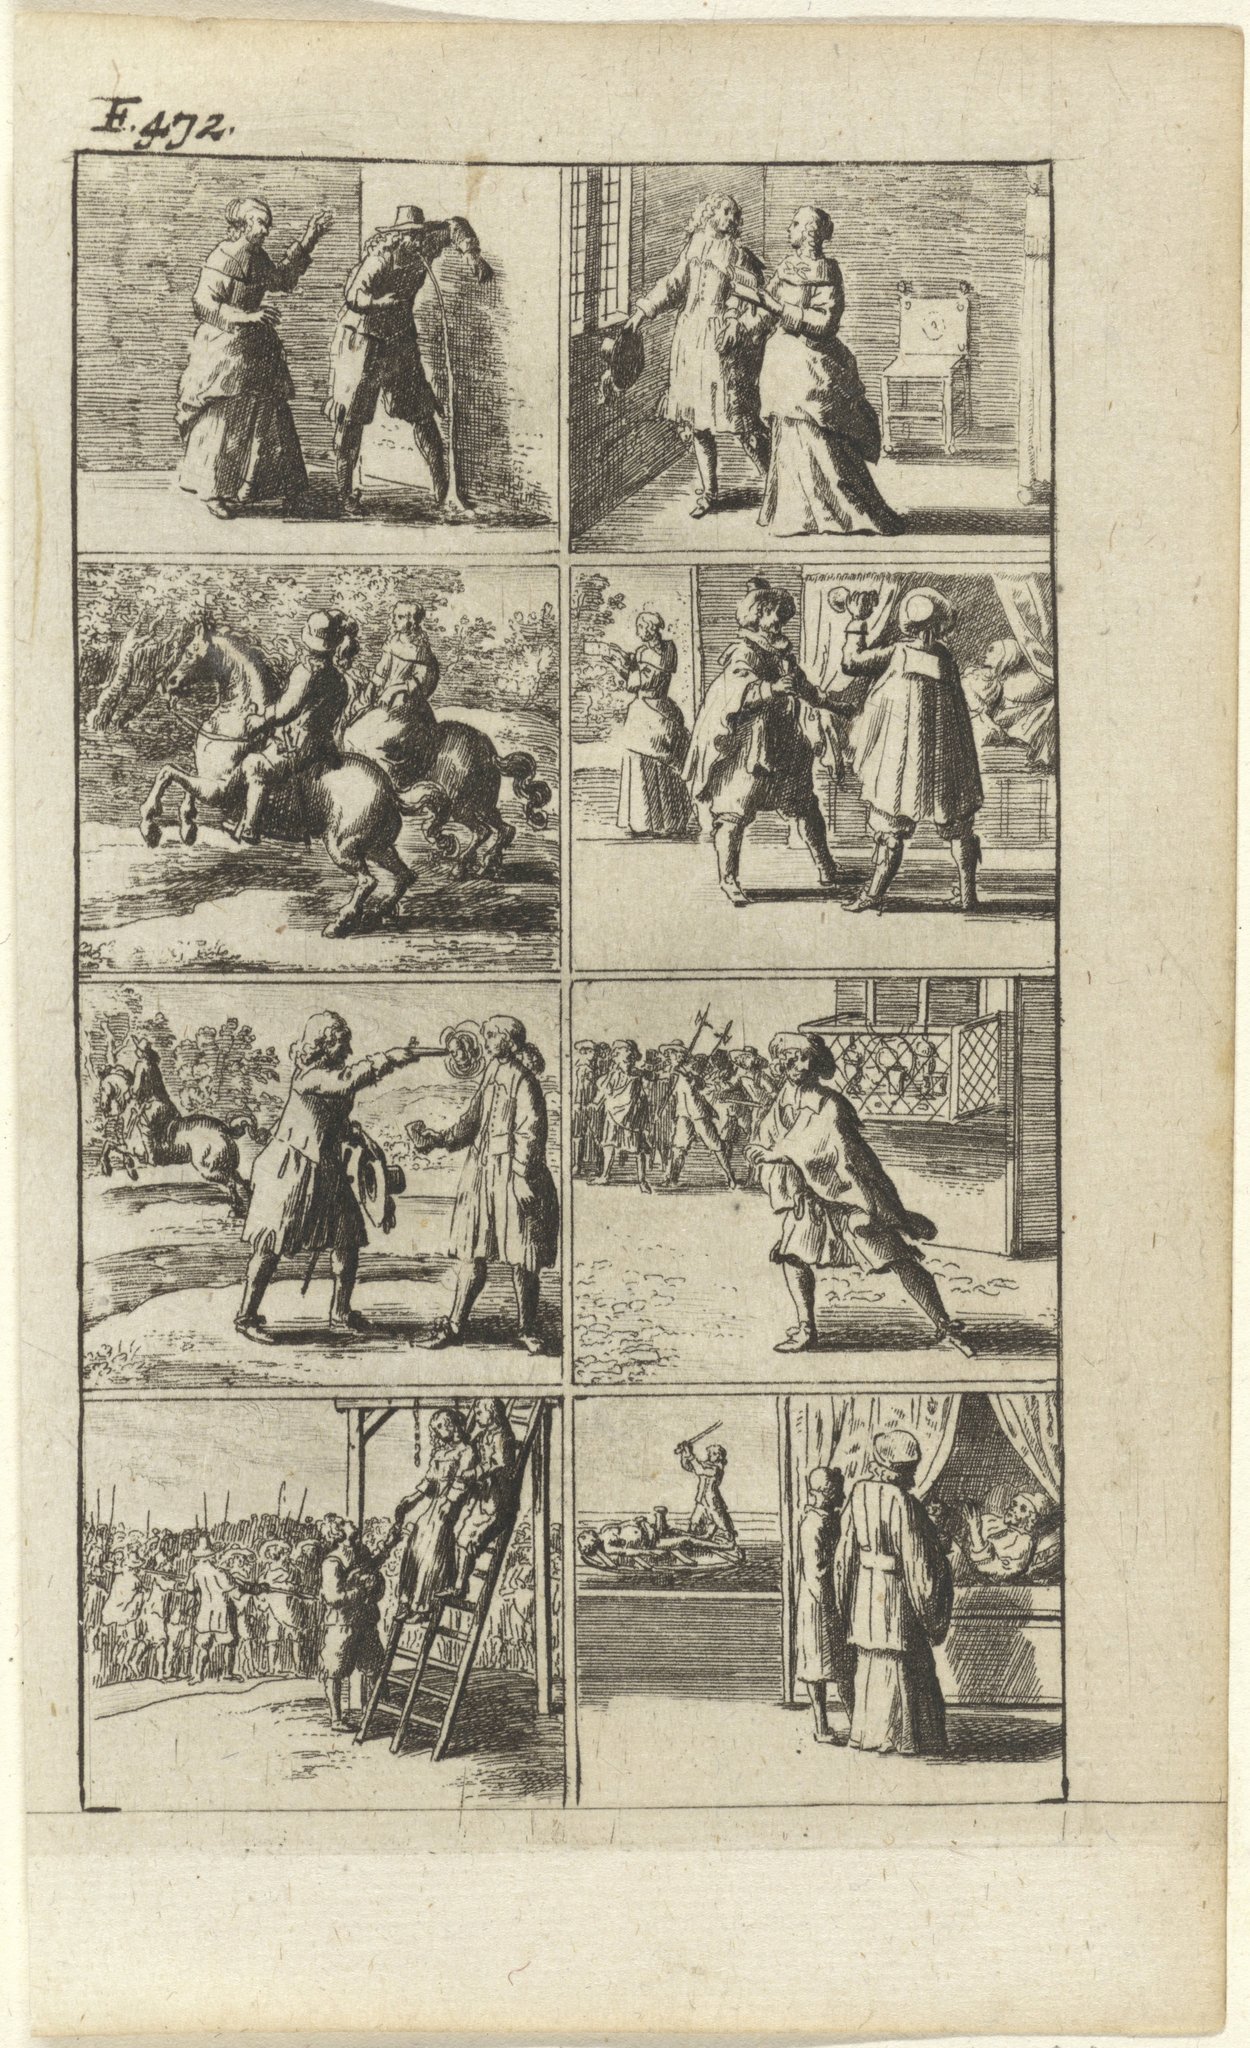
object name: print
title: Verhaal met voorstellingen van moord en doodstraf (F. 472.)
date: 1667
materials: paper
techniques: etching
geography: netherlands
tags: death penalty, execution, murder, fighting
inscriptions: collector's mark: Lugt 2166, collector's mark: Lugt 2760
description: Verhaal in acht scènes met enkele voorstellingen van moord en doodstraf. Onder andere van een man die wordt neergeschoten, een vrouw aan een galg en van een persoon die wordt geradbraakt. Linksboven: F. 472.